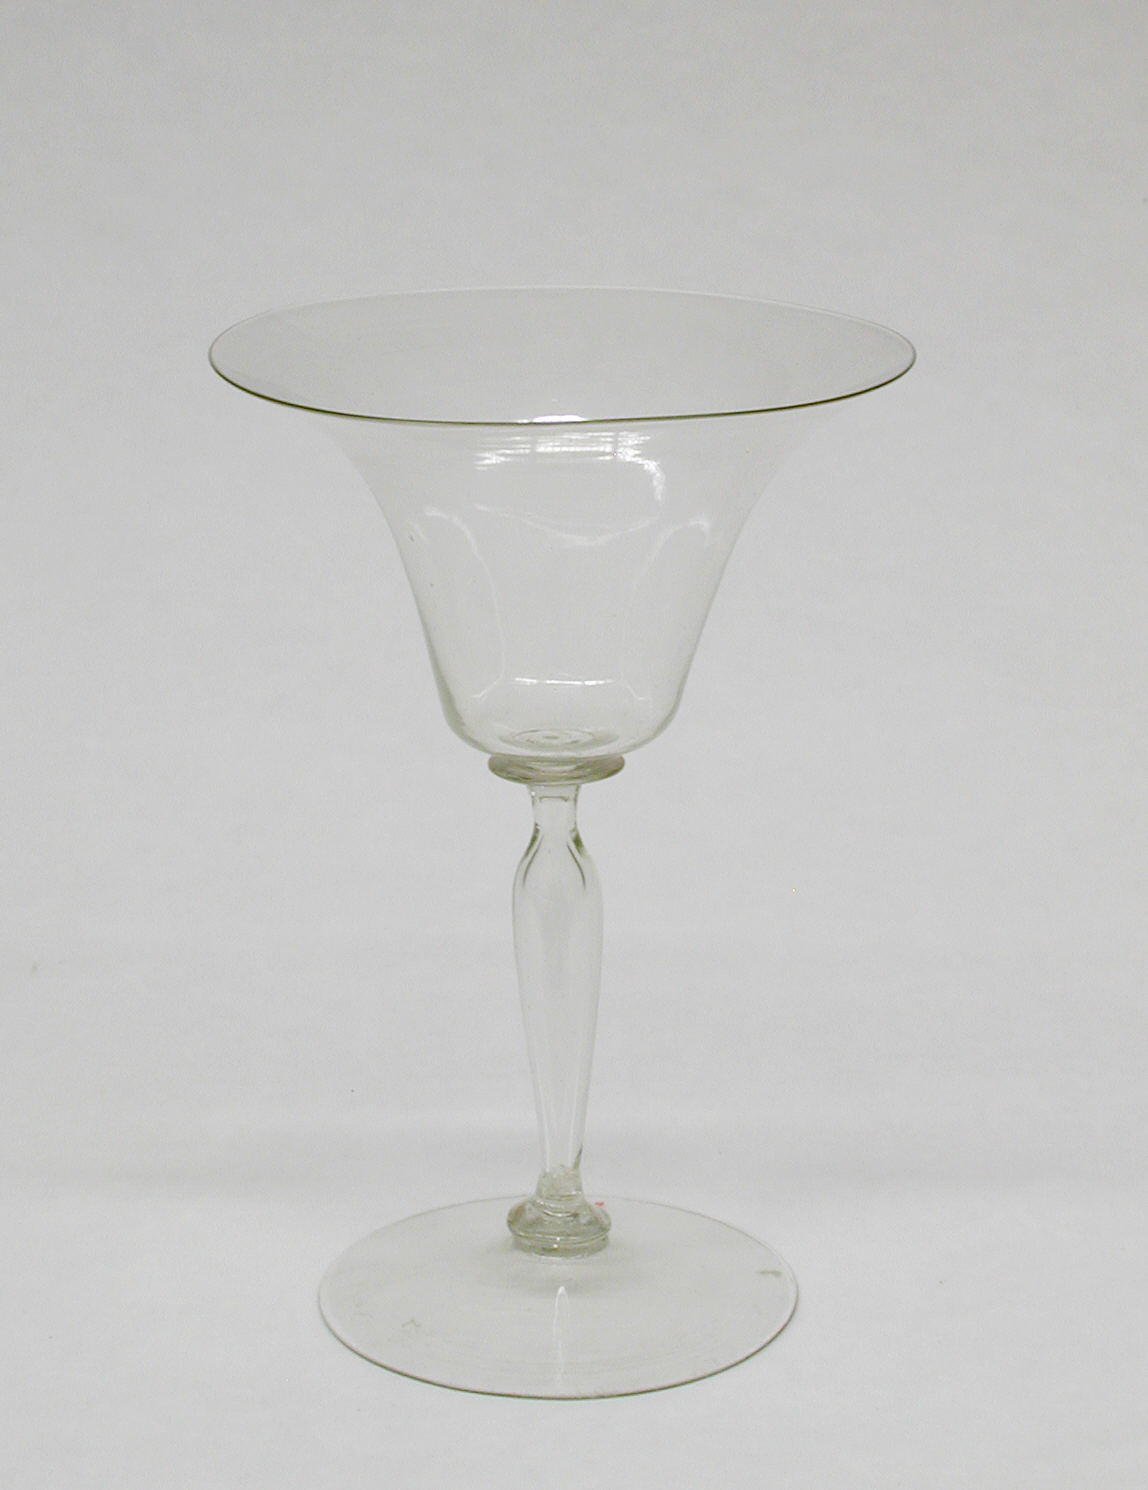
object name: wineglass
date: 1601-1700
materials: glass